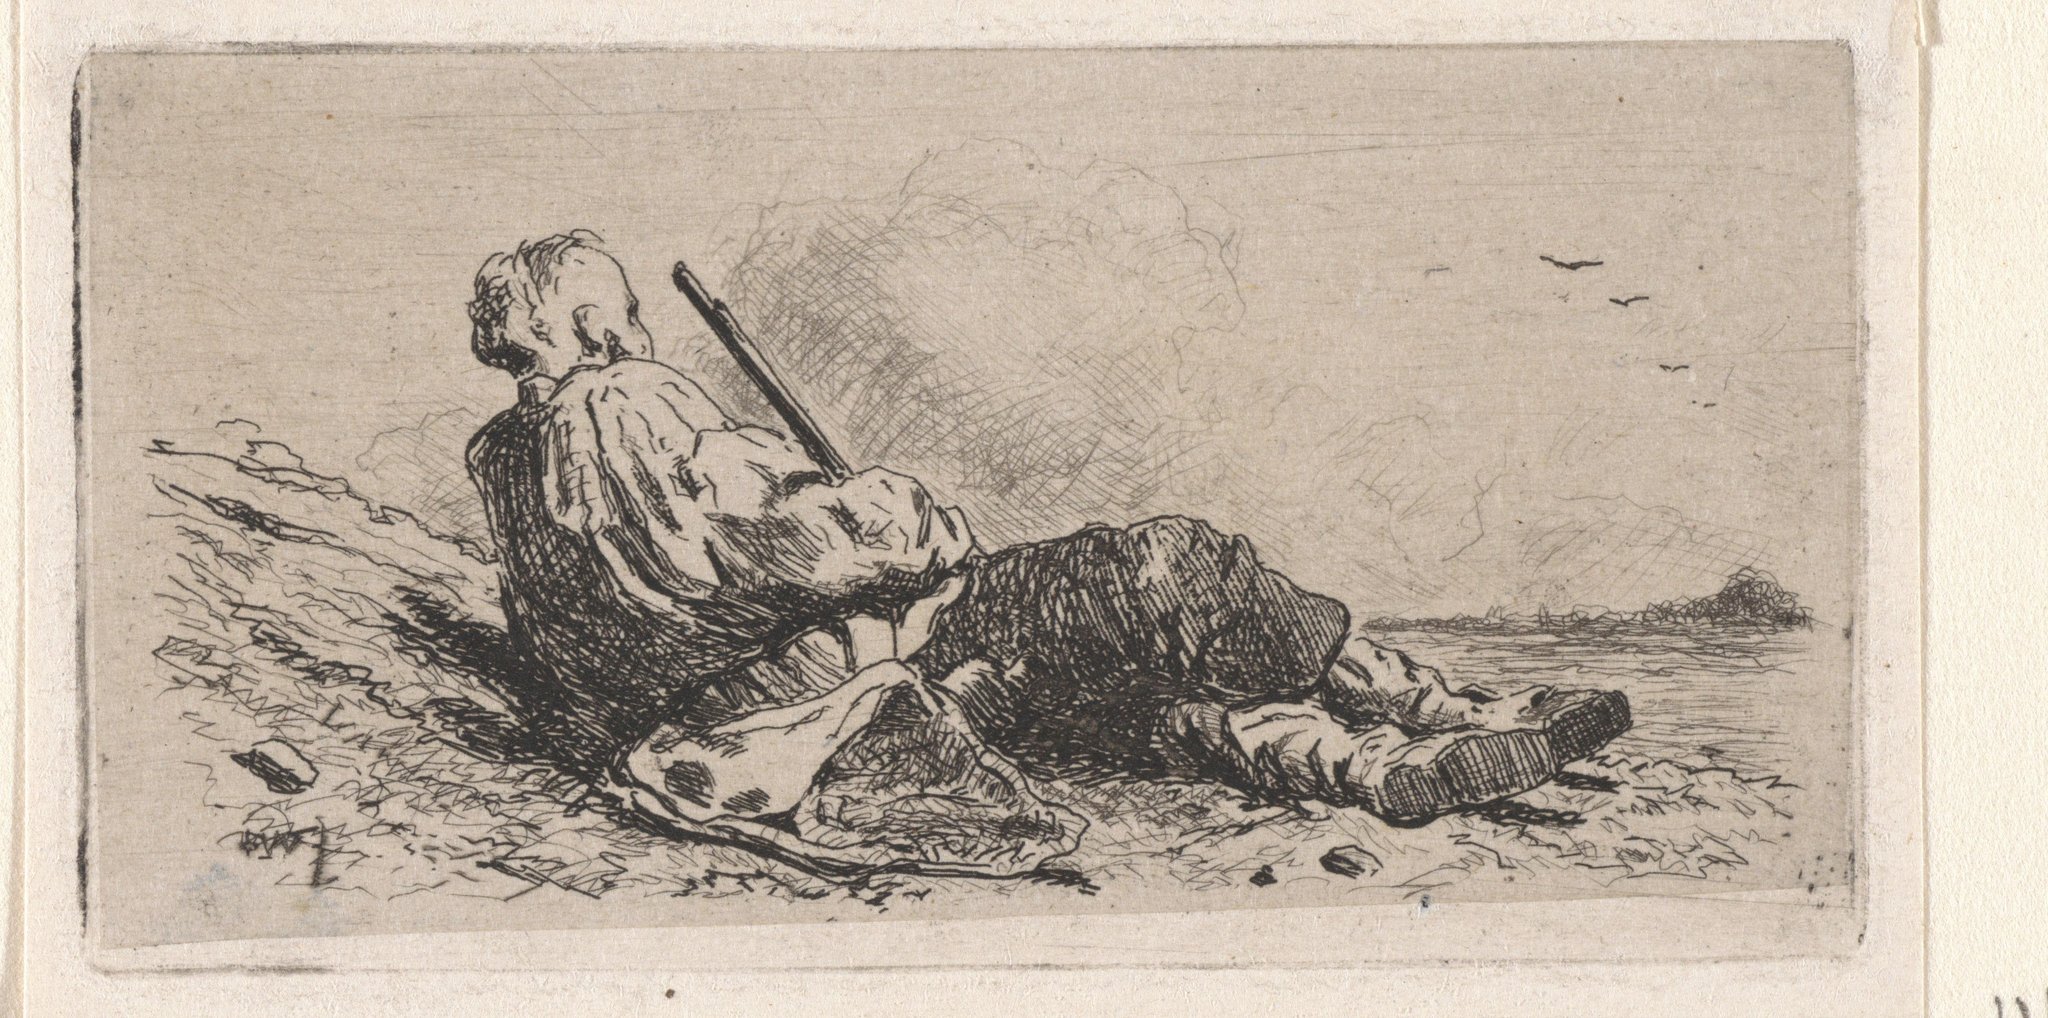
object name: print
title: Liggende jager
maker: jan weissenbruch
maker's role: painter, print maker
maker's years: 1822-1880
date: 1837-1880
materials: paper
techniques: etching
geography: the hague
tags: landscapes, birds, bag, hunter, firearms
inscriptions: collector's mark: Lugt 2228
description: Op de grond ligt een jager naast zijn tas. In de verte vliegen enkele vogels.